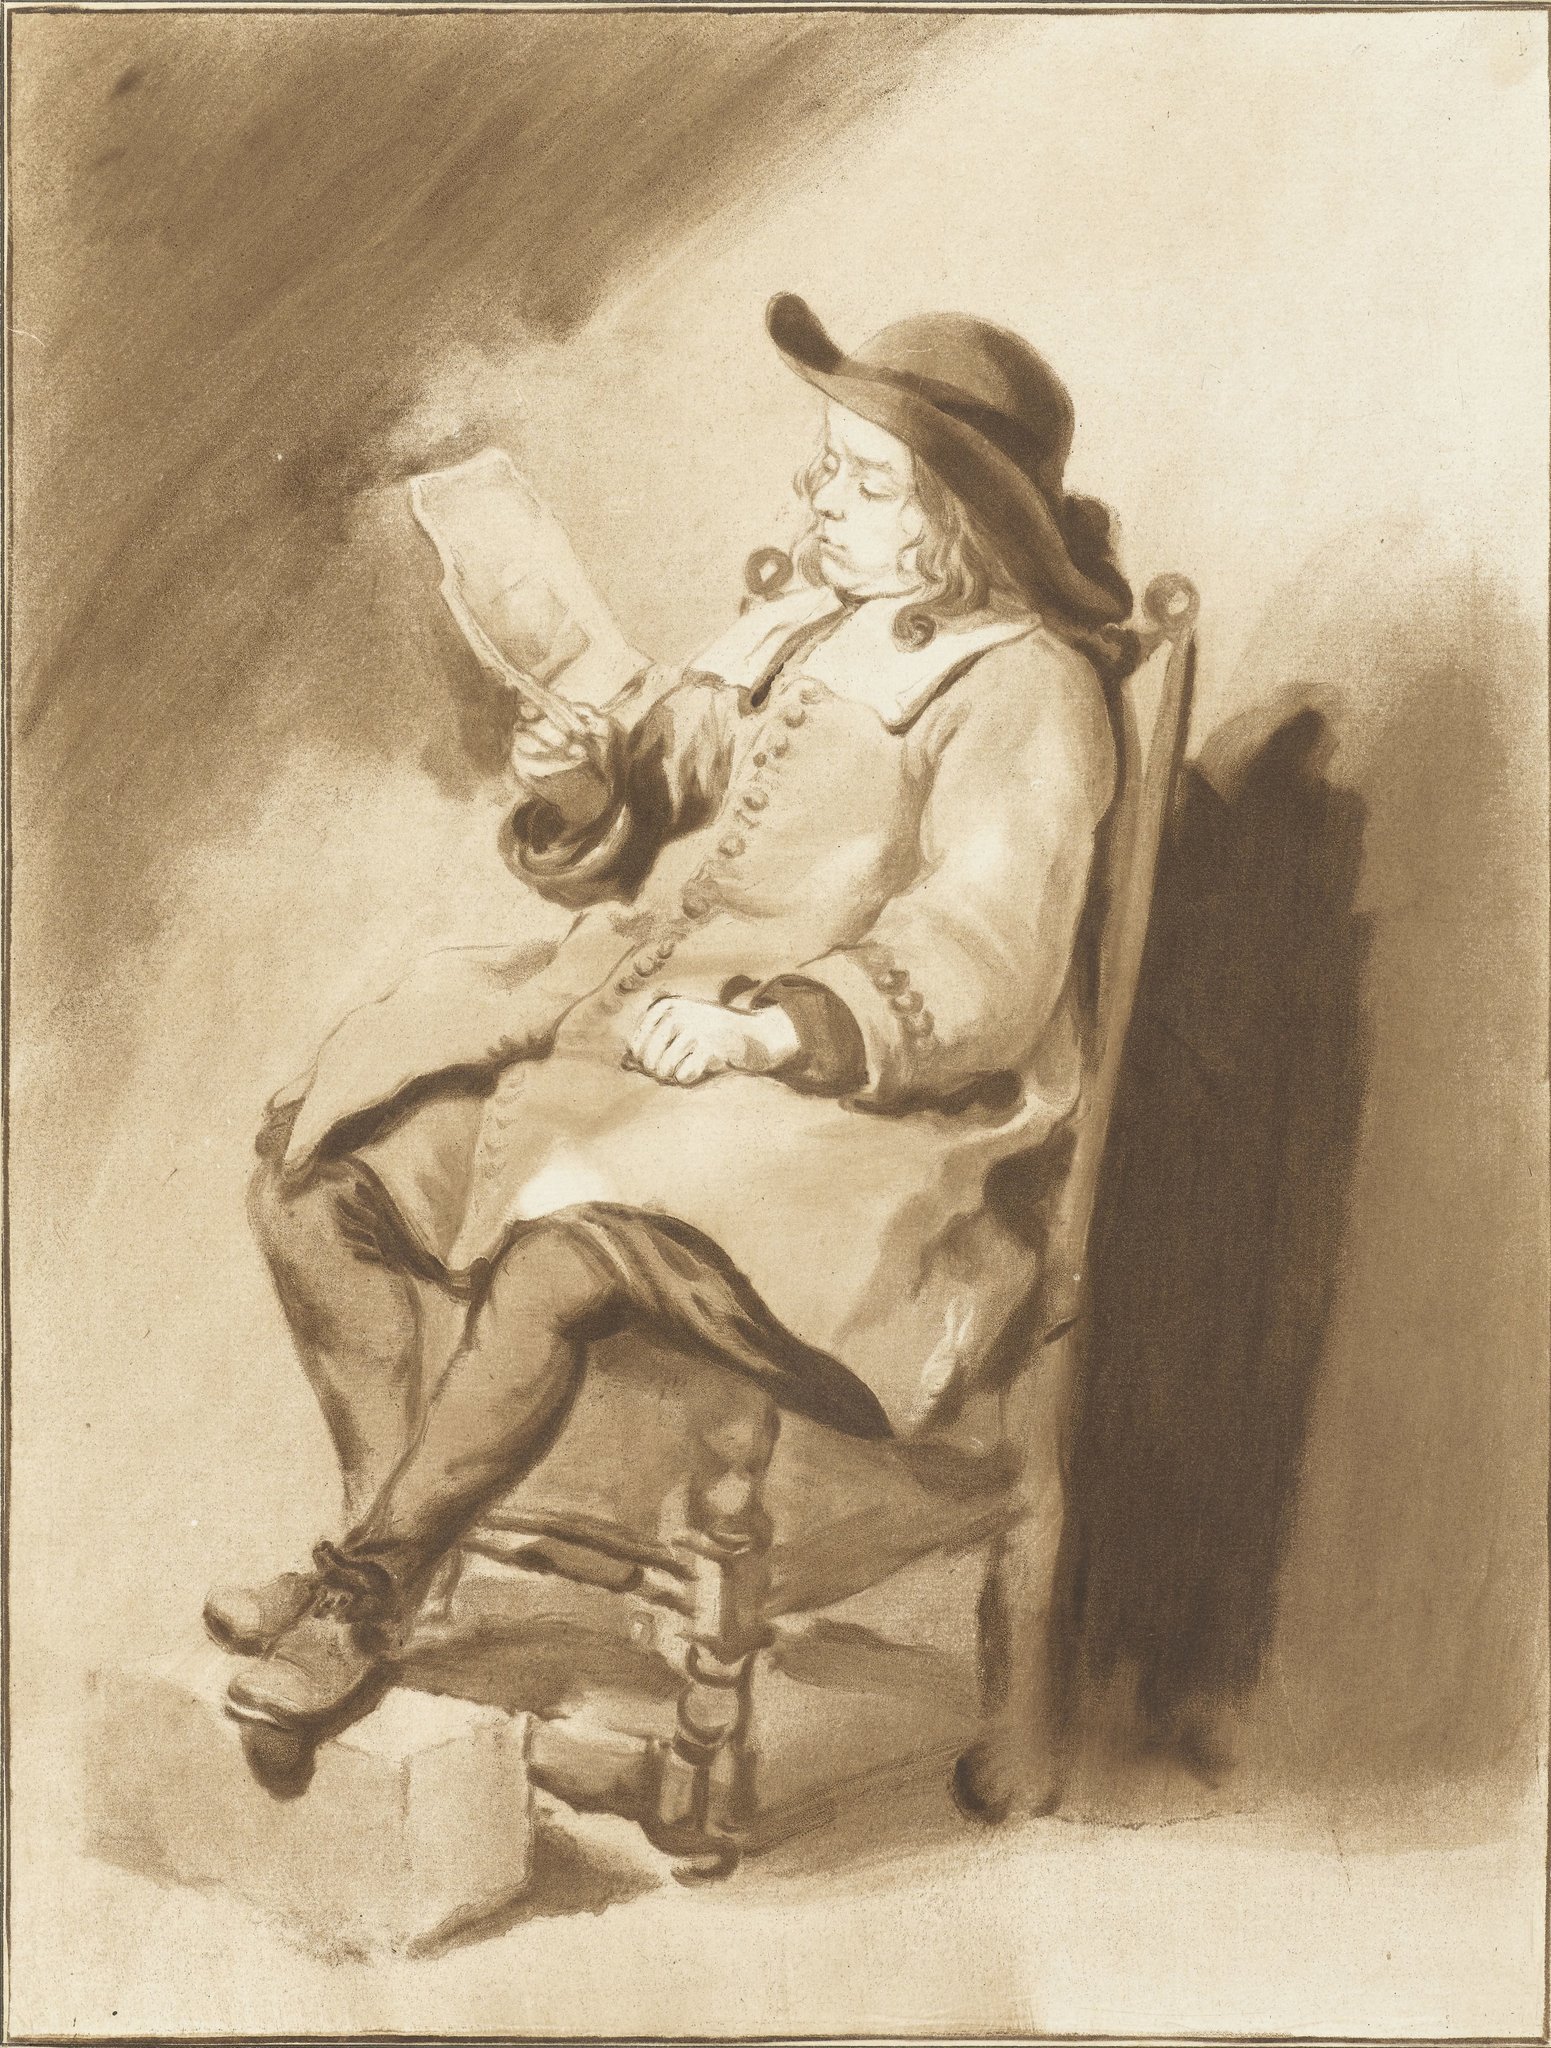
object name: print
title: Lezende jongeling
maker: jurriaan cootwijck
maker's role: print maker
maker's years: 1714-1798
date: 1724-1798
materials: paper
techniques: print drawing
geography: amsterdam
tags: reading, youth, adolescent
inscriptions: collector's mark: Lugt 2228, collector's mark: Lugt 2760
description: Een jongeling in een leunstoel leest een blad papier.